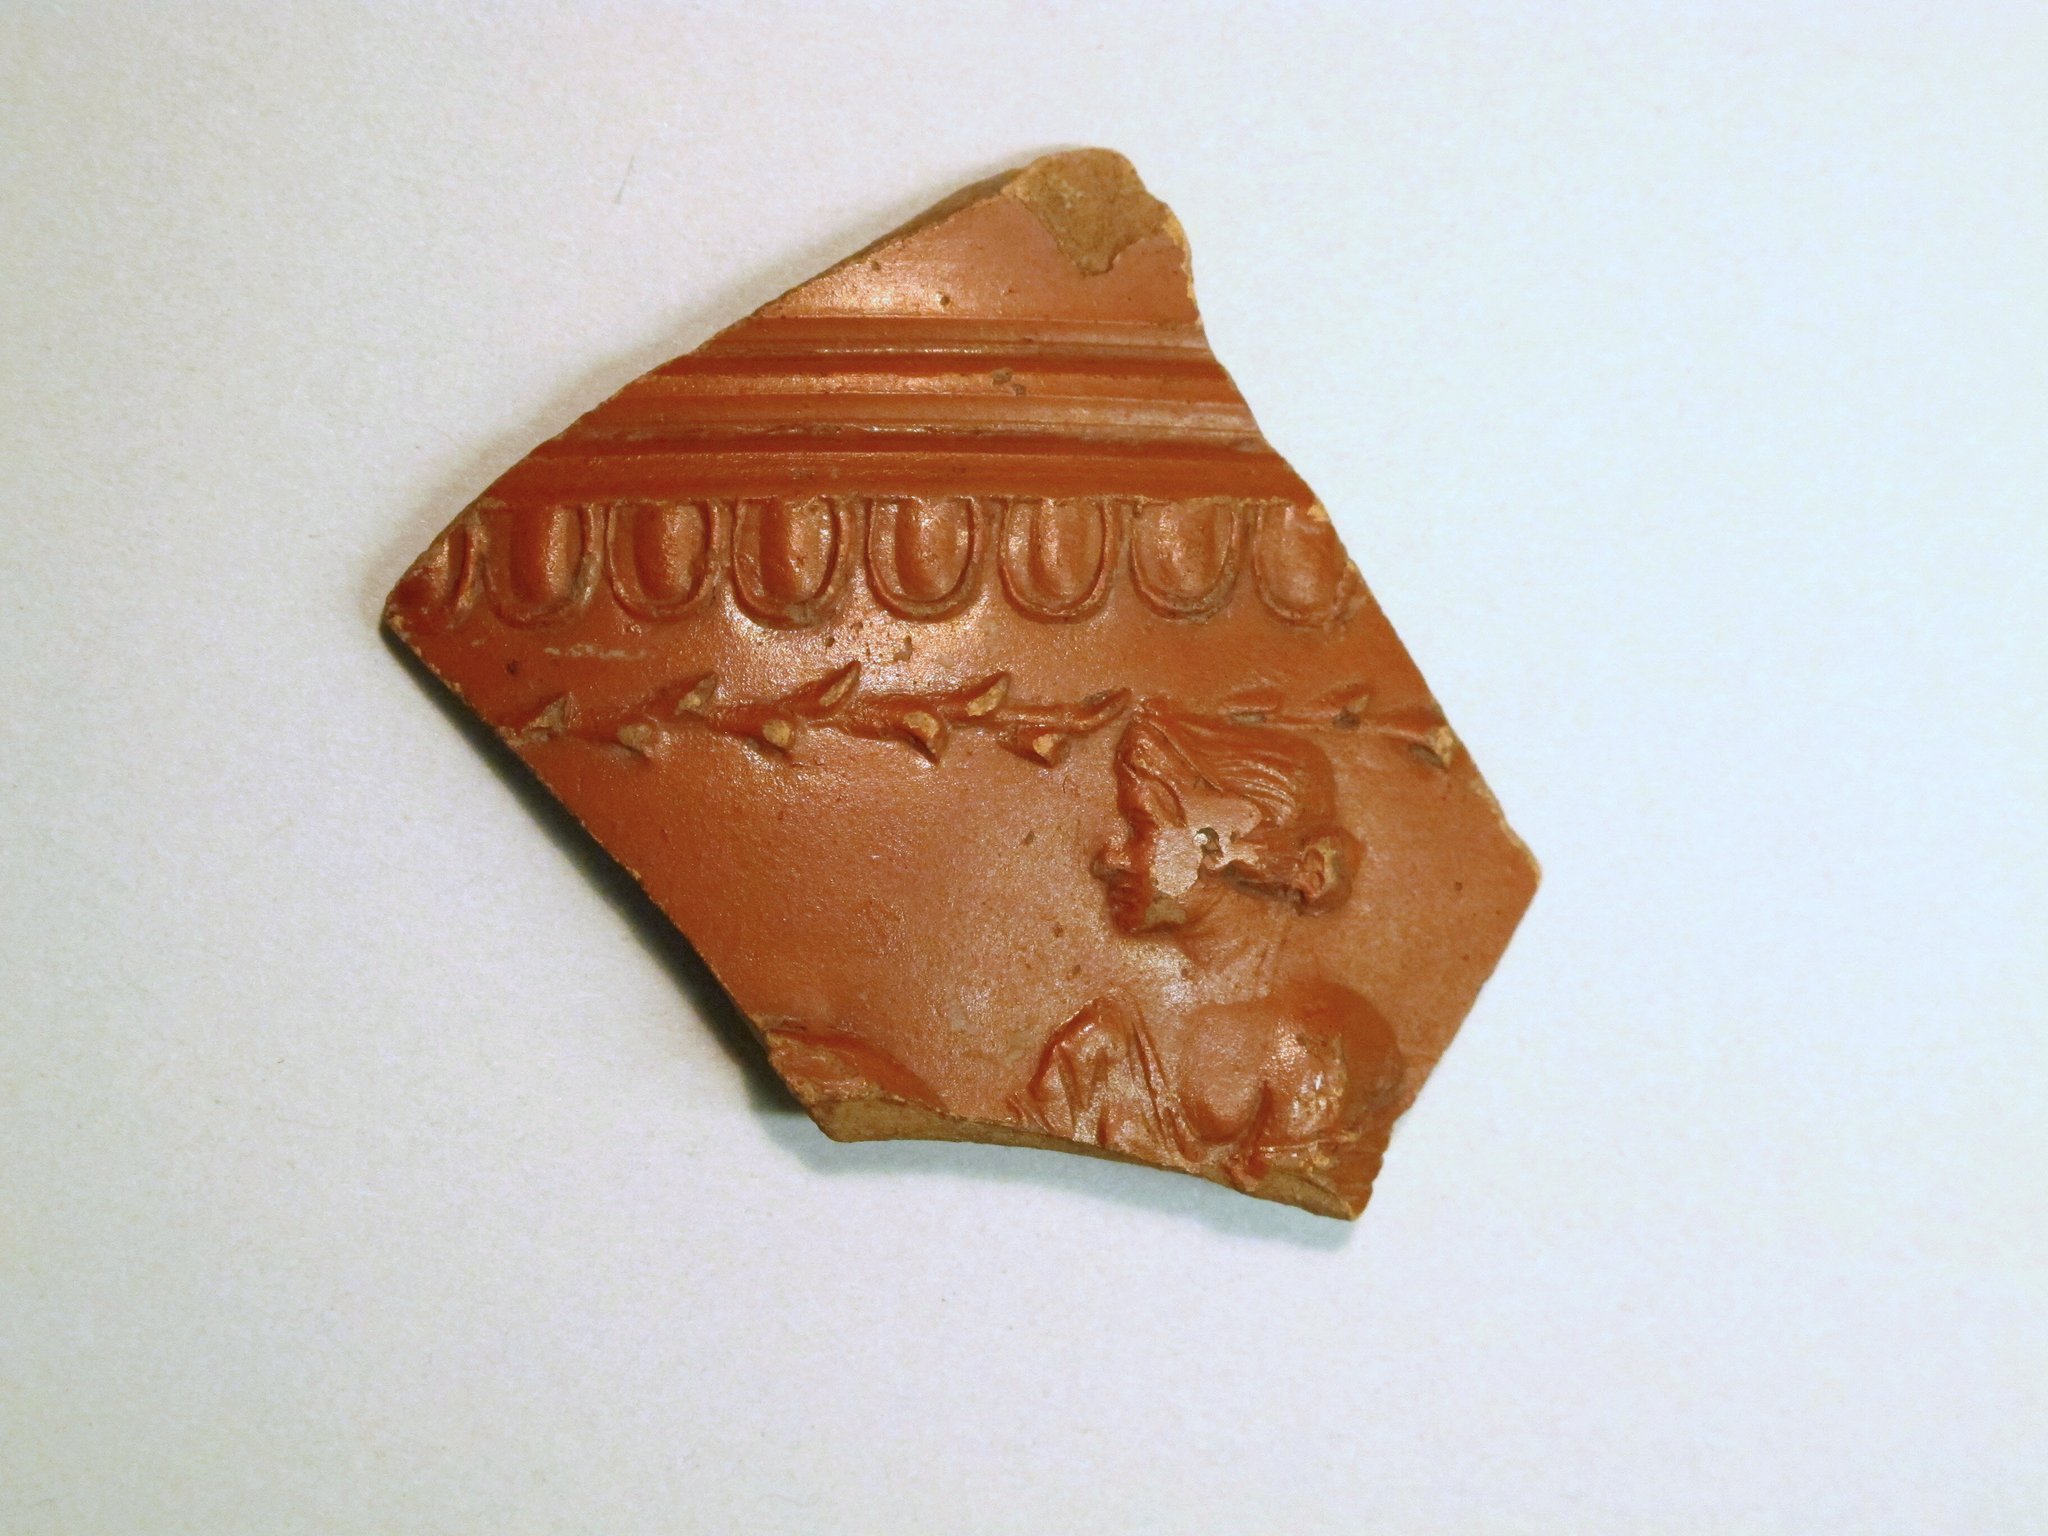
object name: vase fragment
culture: roman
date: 100 BCE-100 CE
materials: terracotta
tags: women